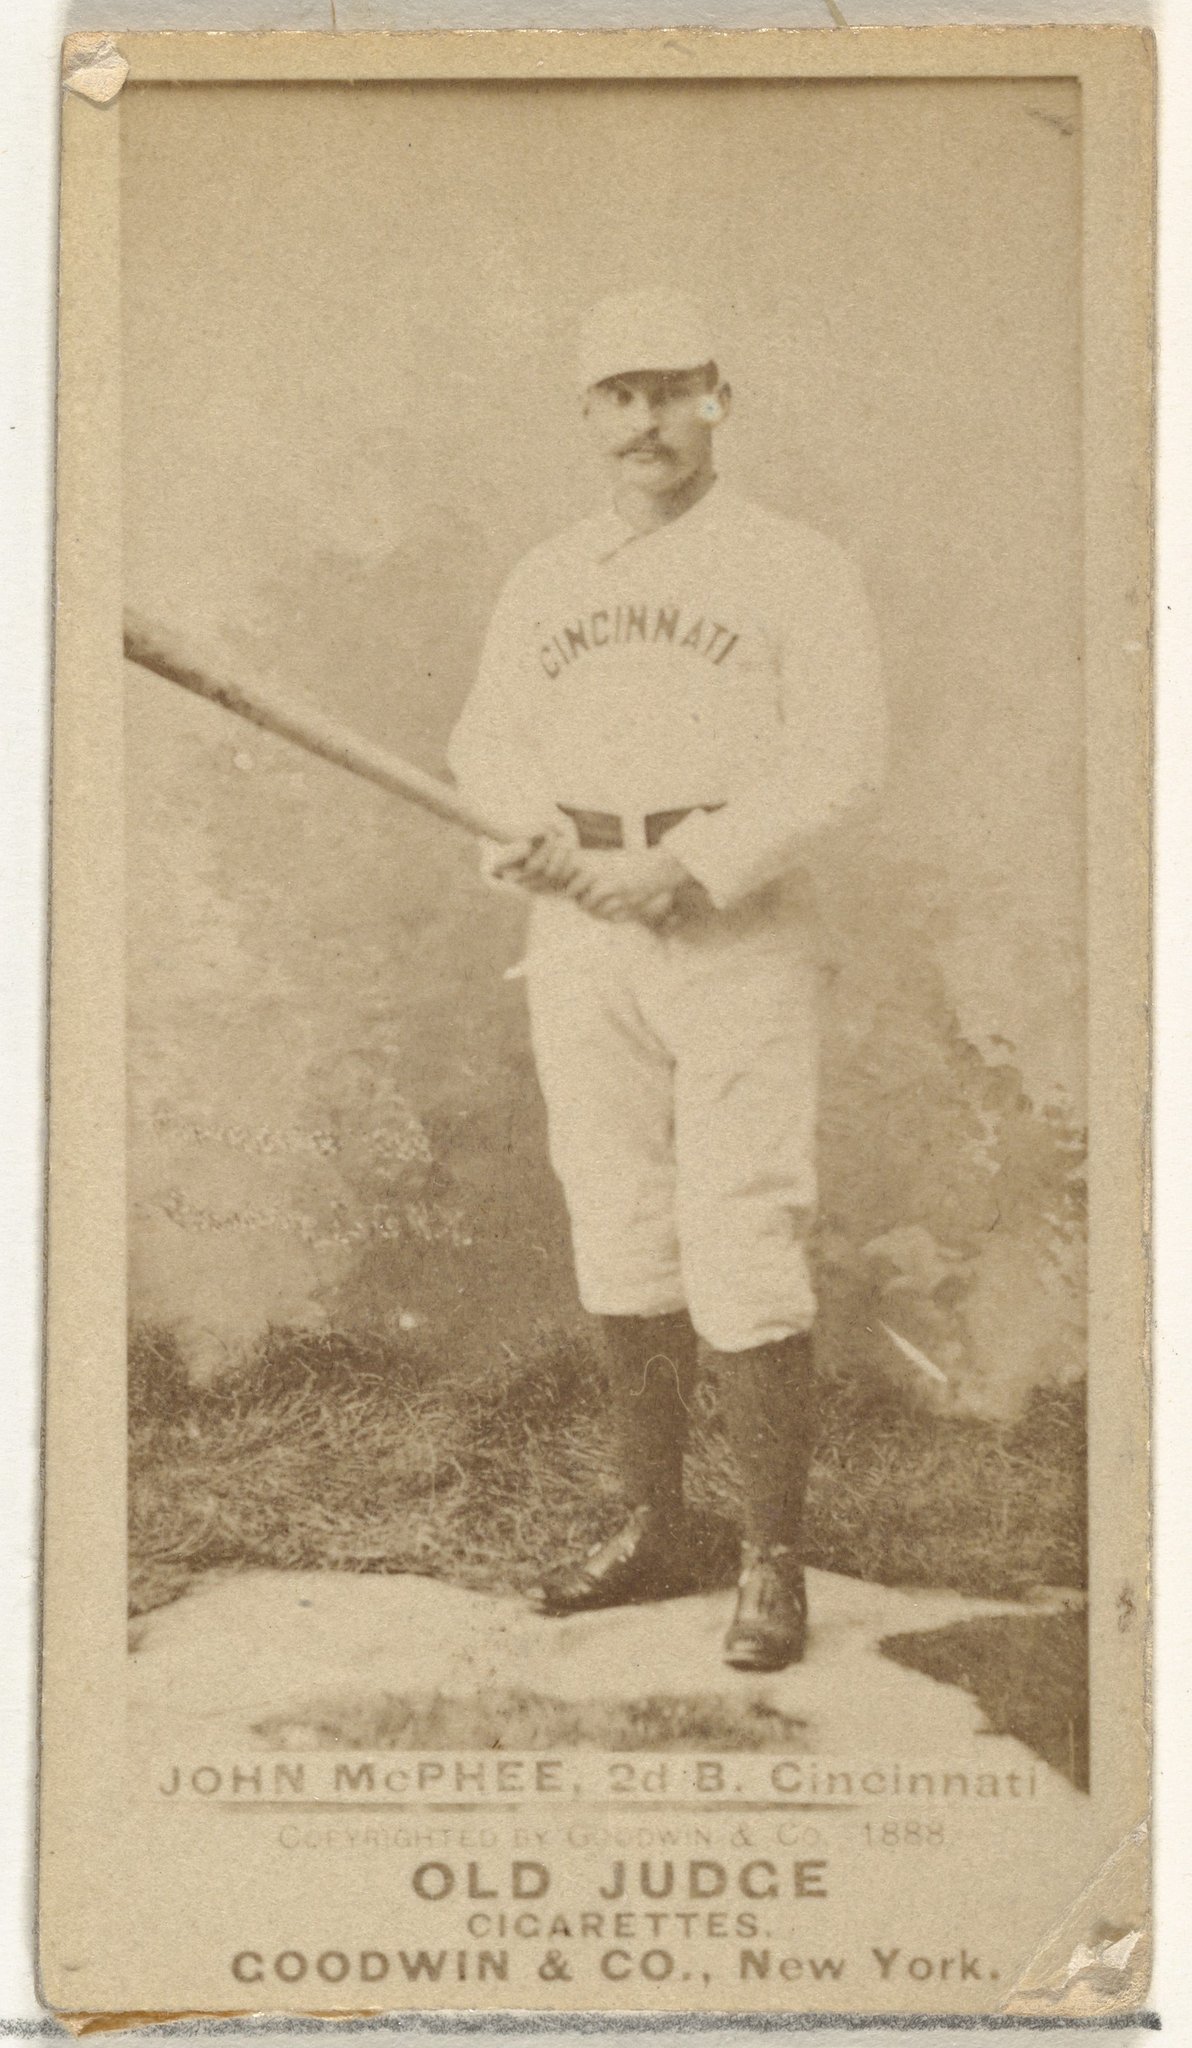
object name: baseball card, photograph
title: John Alexander "Bid" McPhee, 2nd Base, Cincinnati, from the Old Judge series (N172) for Old Judge Cigarettes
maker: goodwin & company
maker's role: publisher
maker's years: 1850-1950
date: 1888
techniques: albumen silver print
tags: men,portraits,baseball,athletes